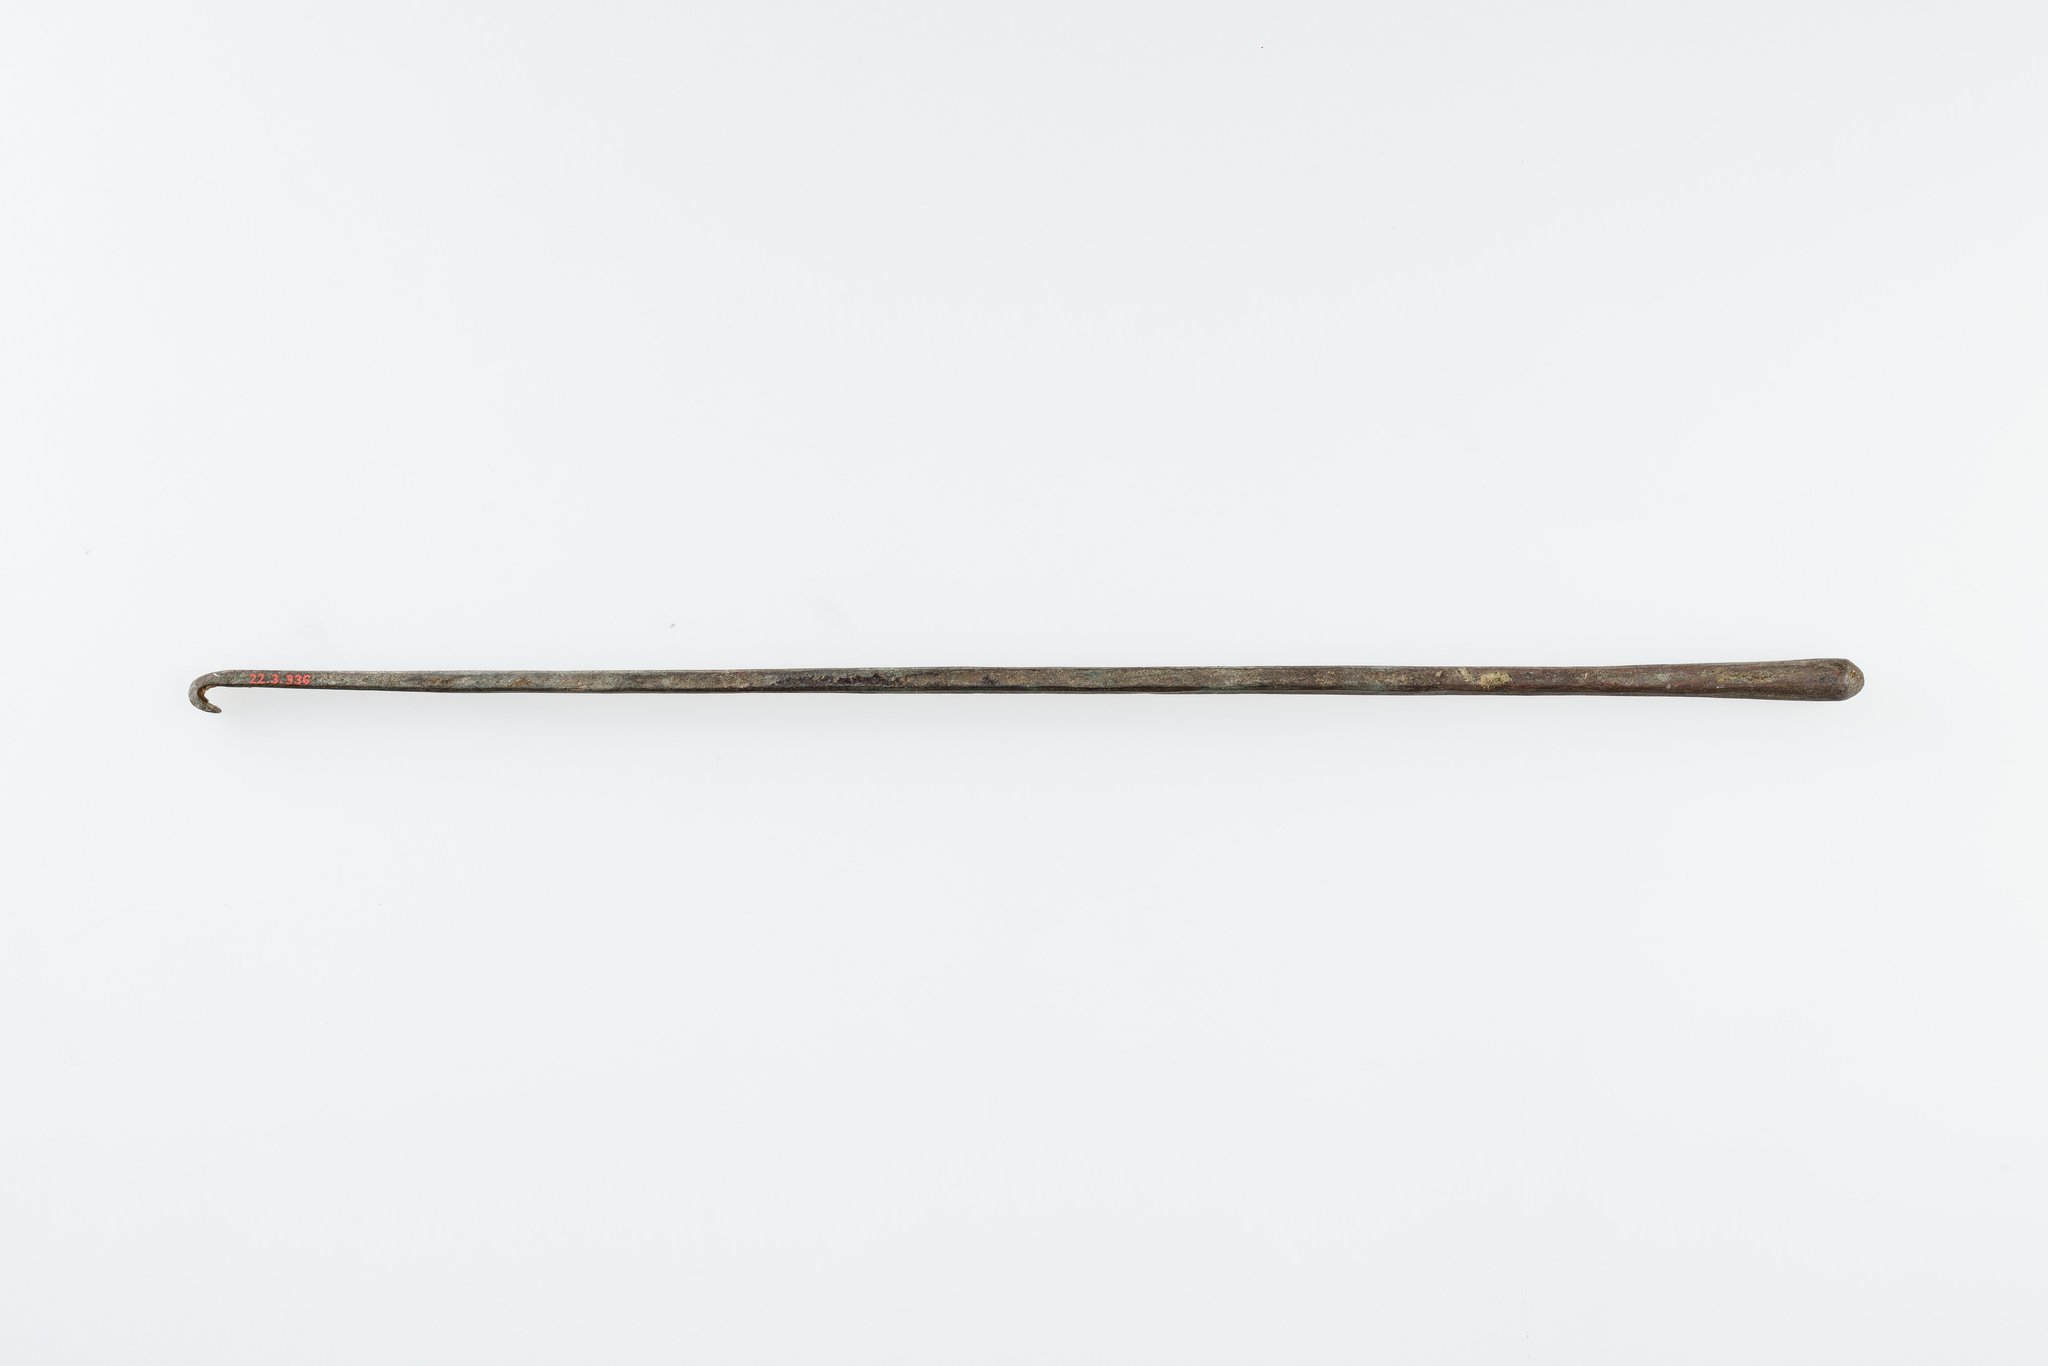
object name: pot hook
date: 332-330 BCE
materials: bronze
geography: egypt